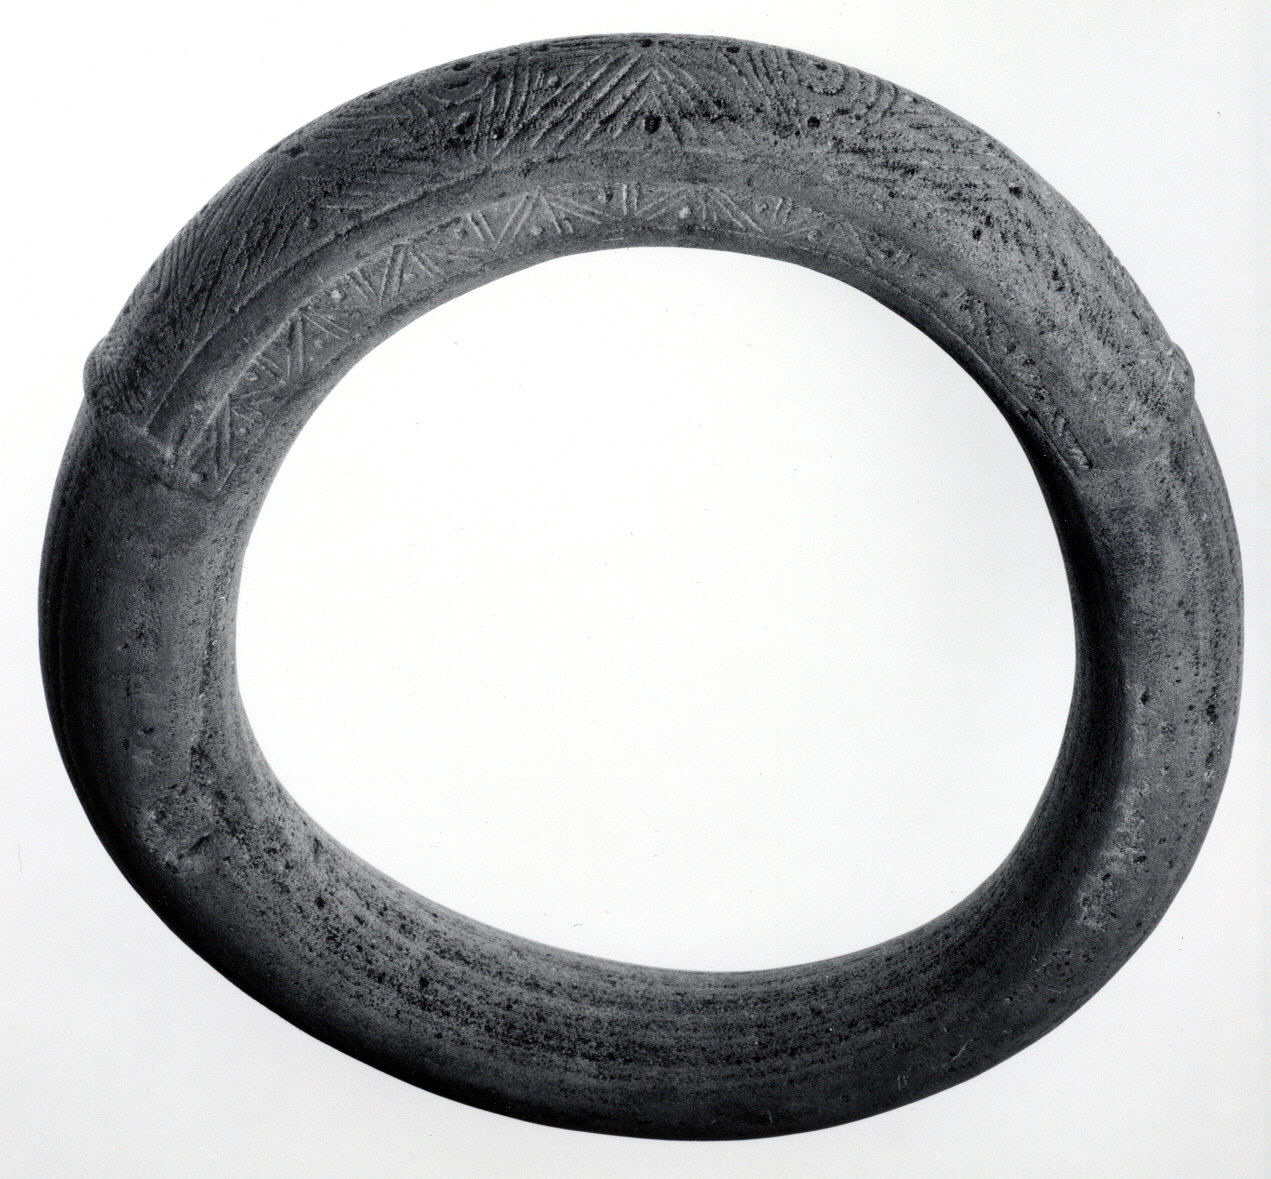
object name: yoke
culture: taíno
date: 1201-1500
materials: stone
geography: dominican republic